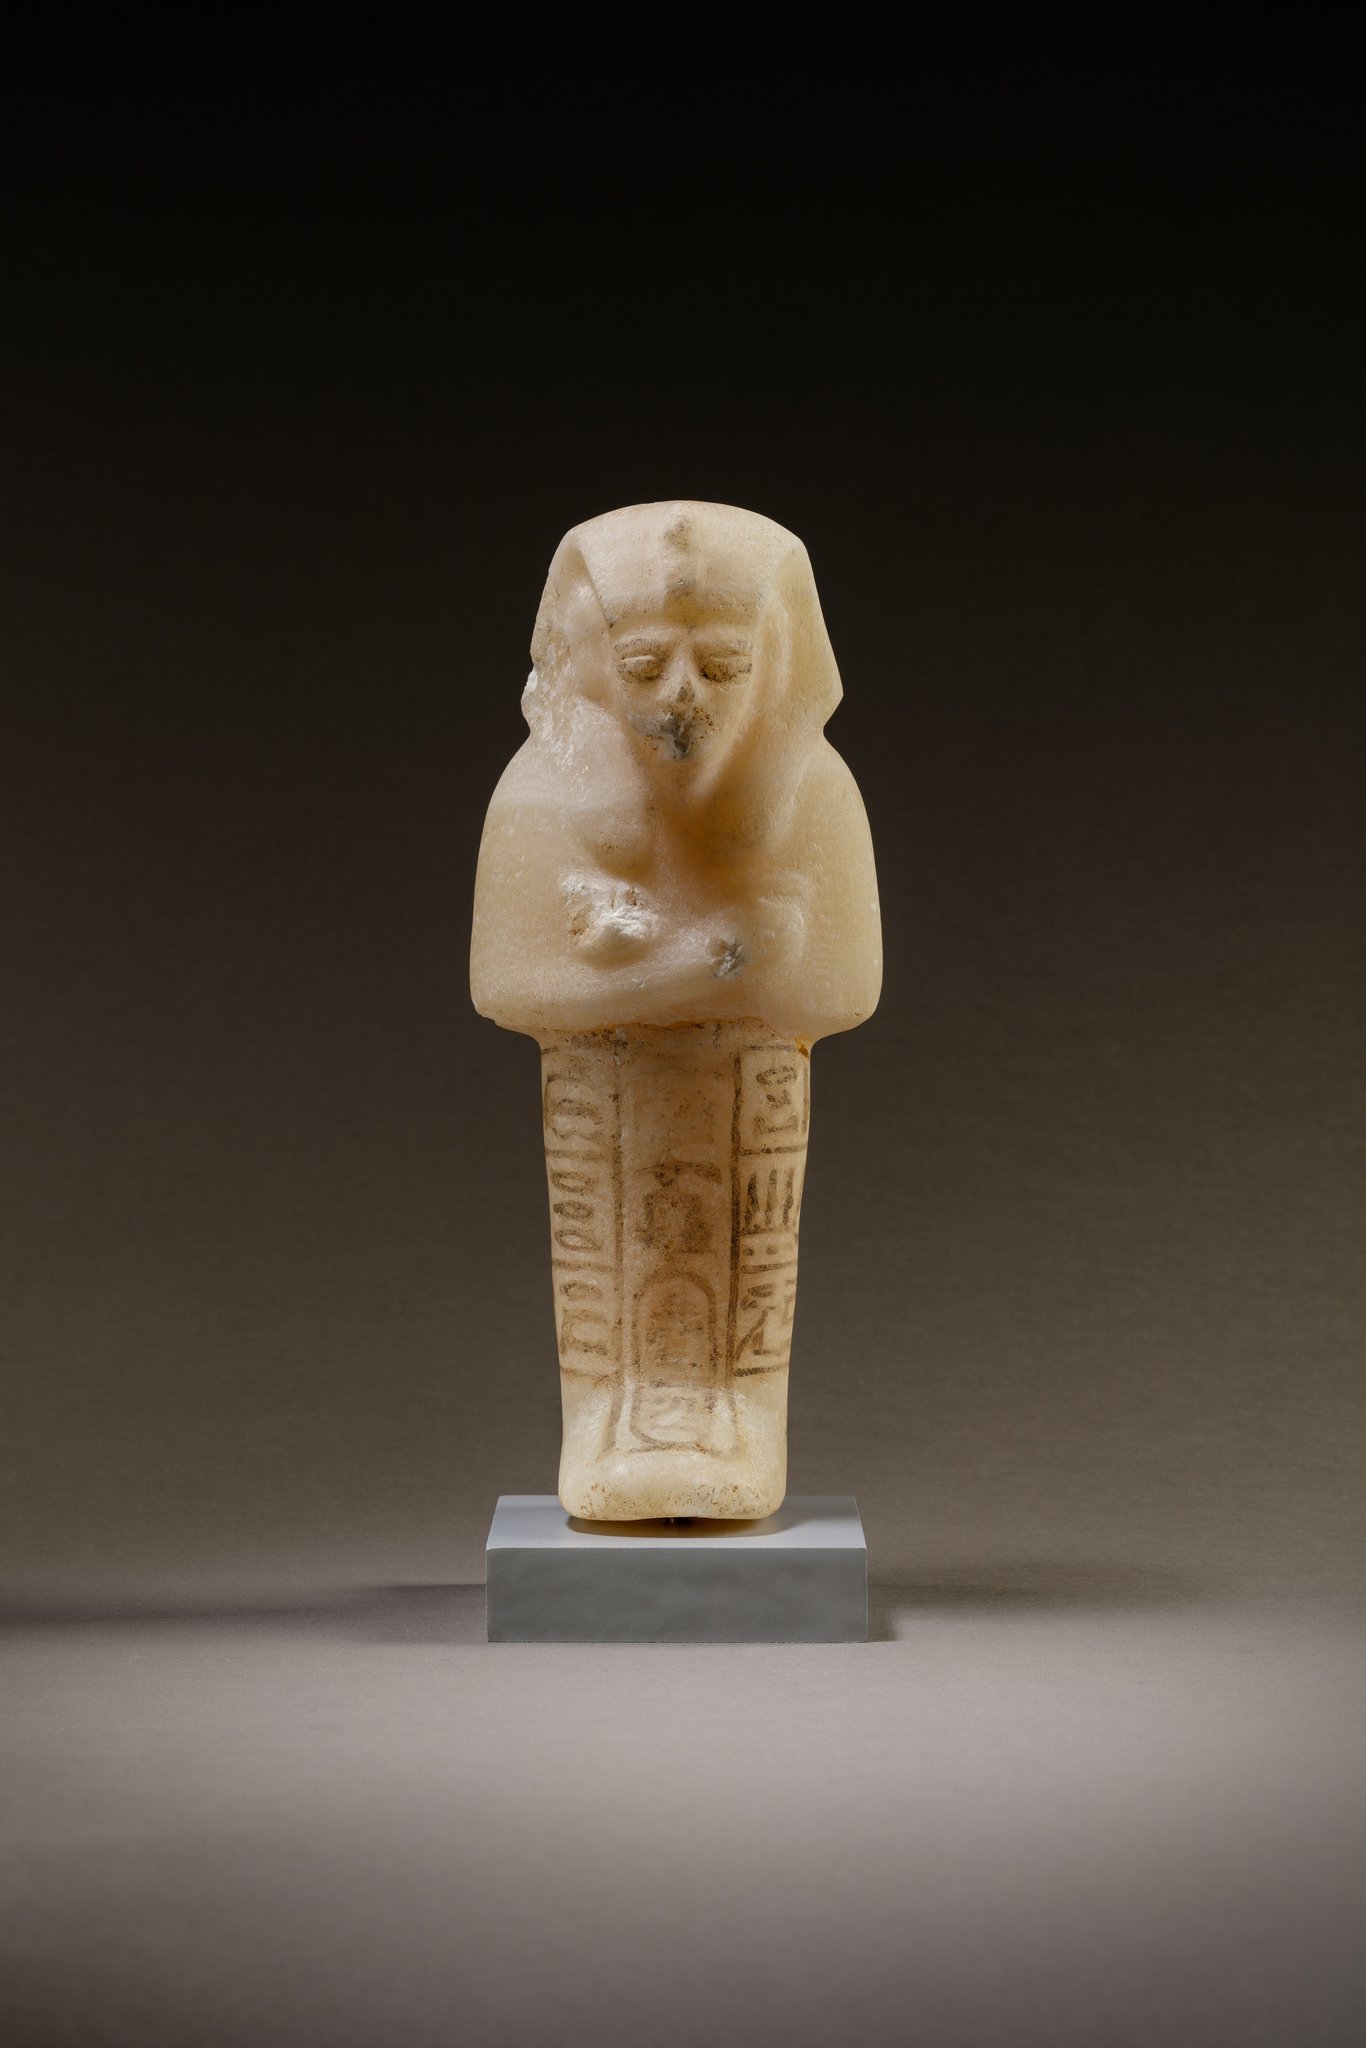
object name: shabti, siptah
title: Shabti of Siptah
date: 1194-1188 BCE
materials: stone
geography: egypt